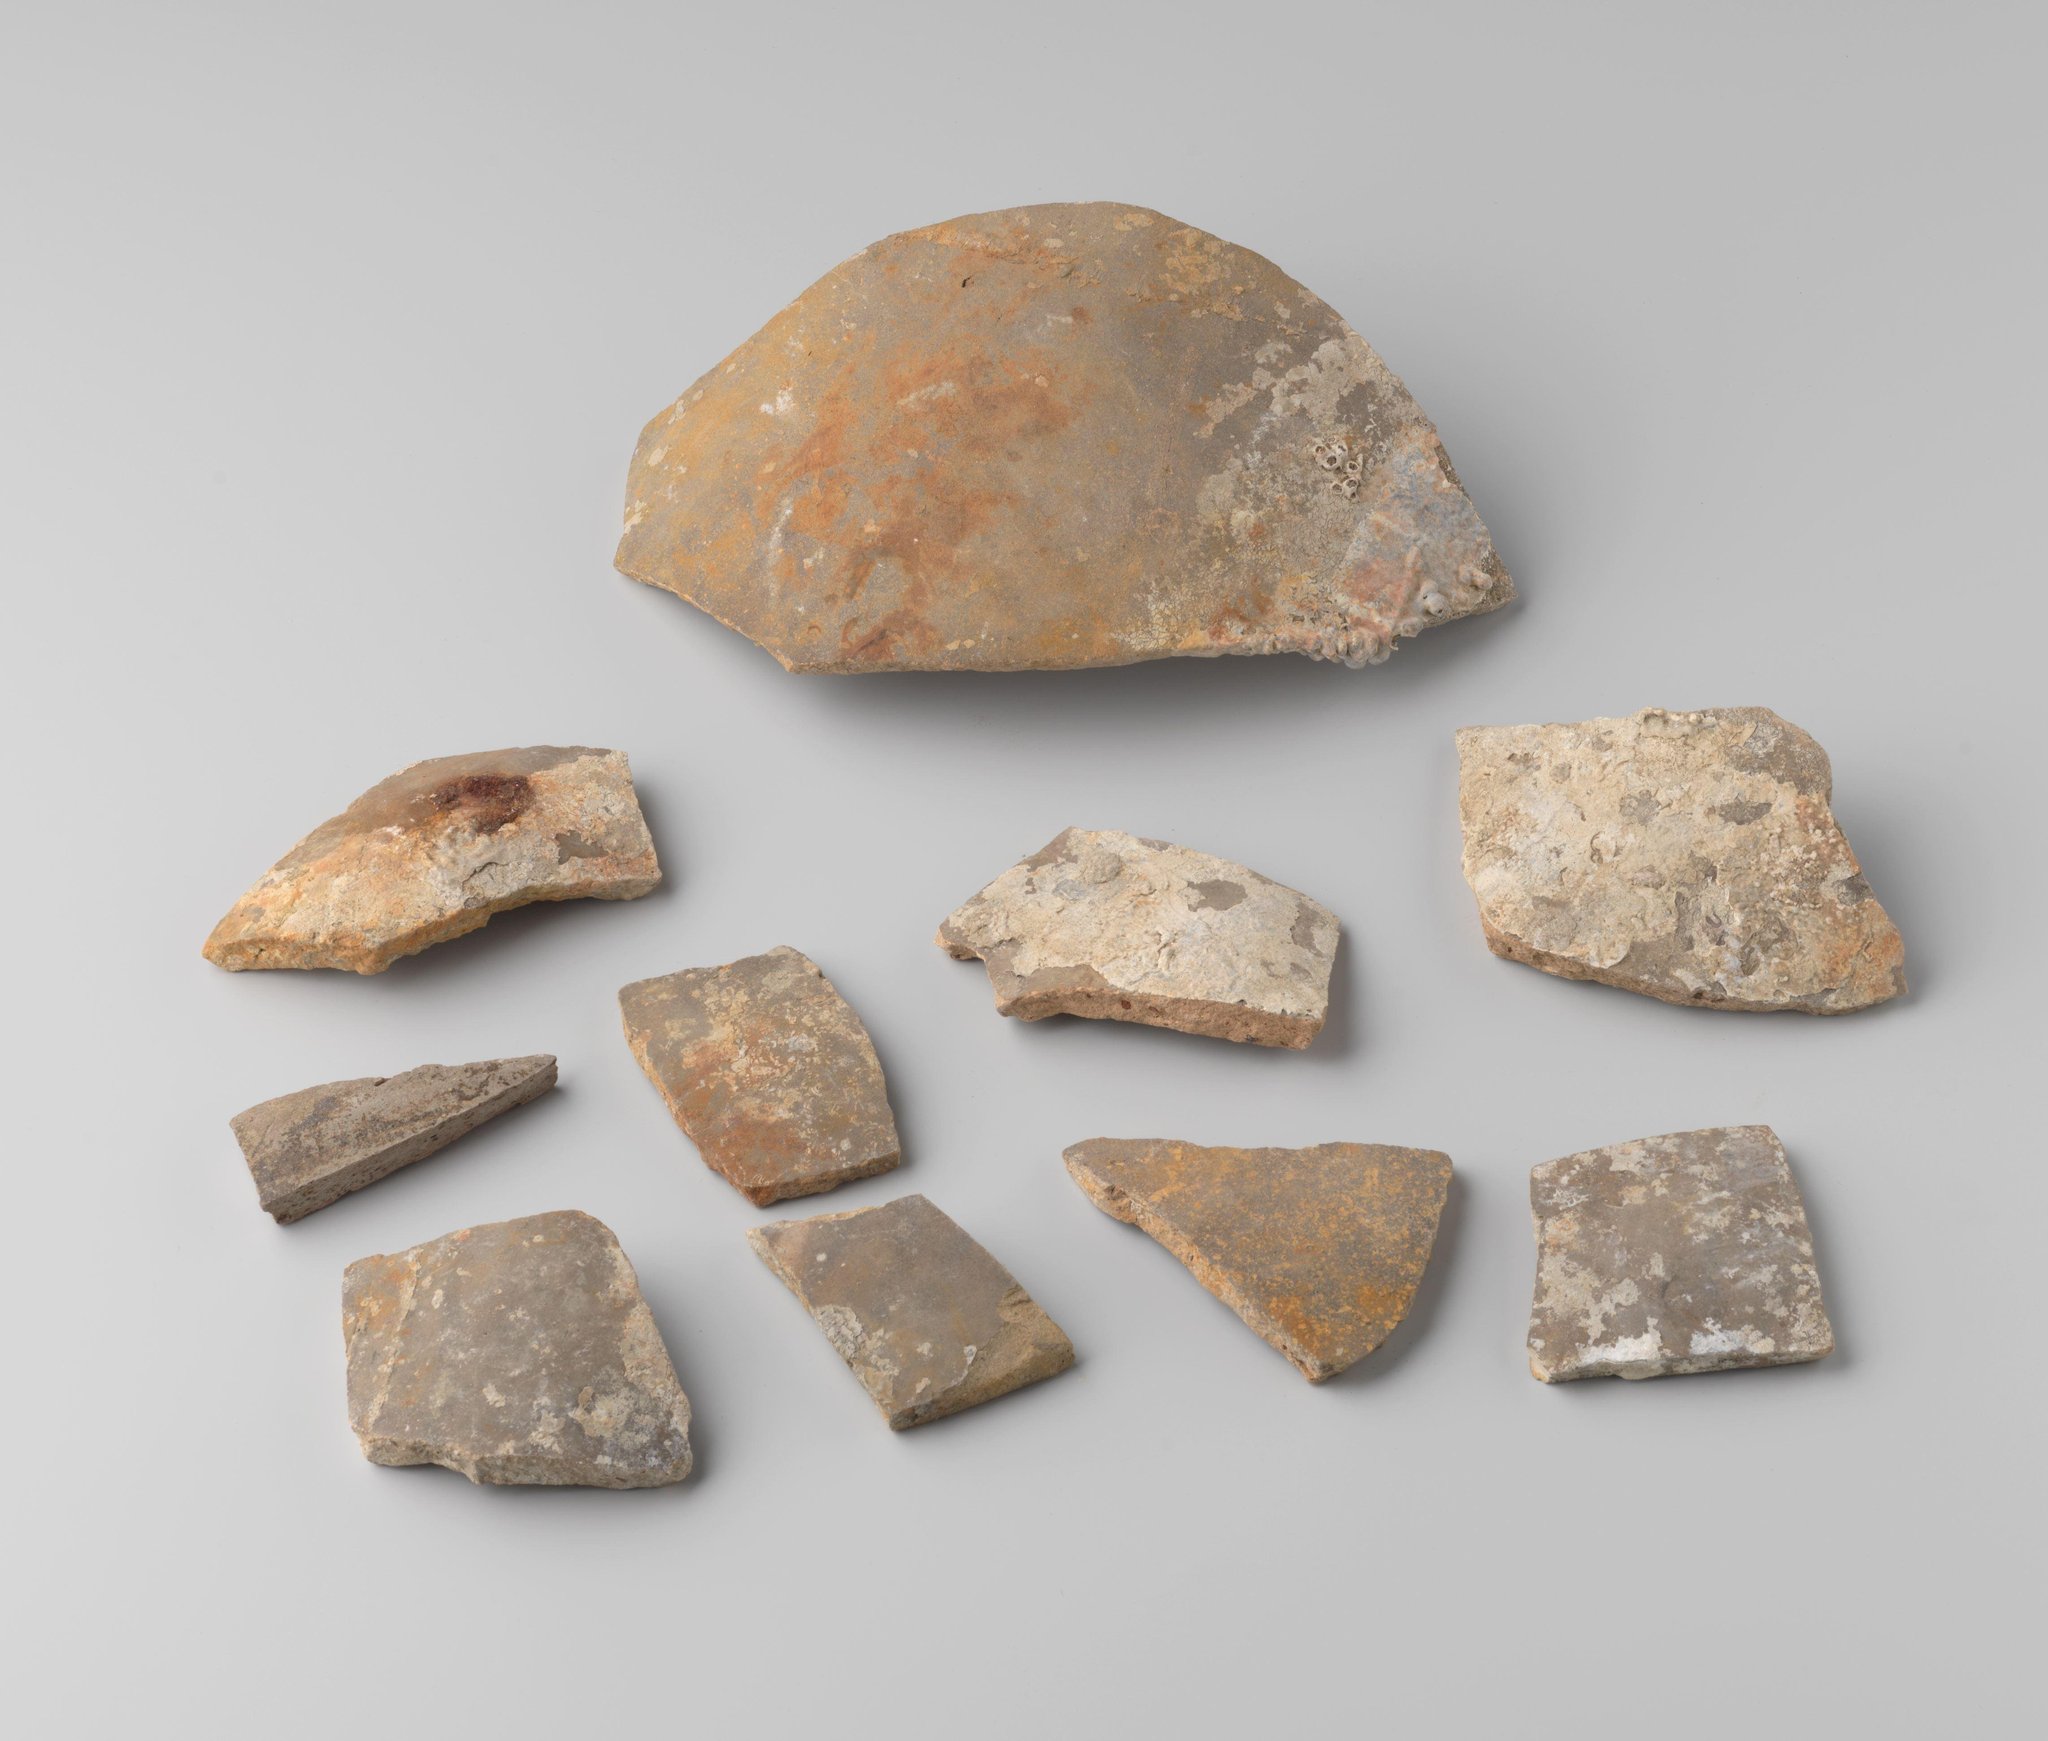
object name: sherd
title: Scherven van martavanen uit V.O.C.-schip de 'Witte Leeuw'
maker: Anonymous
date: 1613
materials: porcelain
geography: southeast asia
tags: verenigde oostindische compagnie, sint-helena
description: Scherven van martavanen uit V.O.C.-schip de 'Witte Leeuw'.